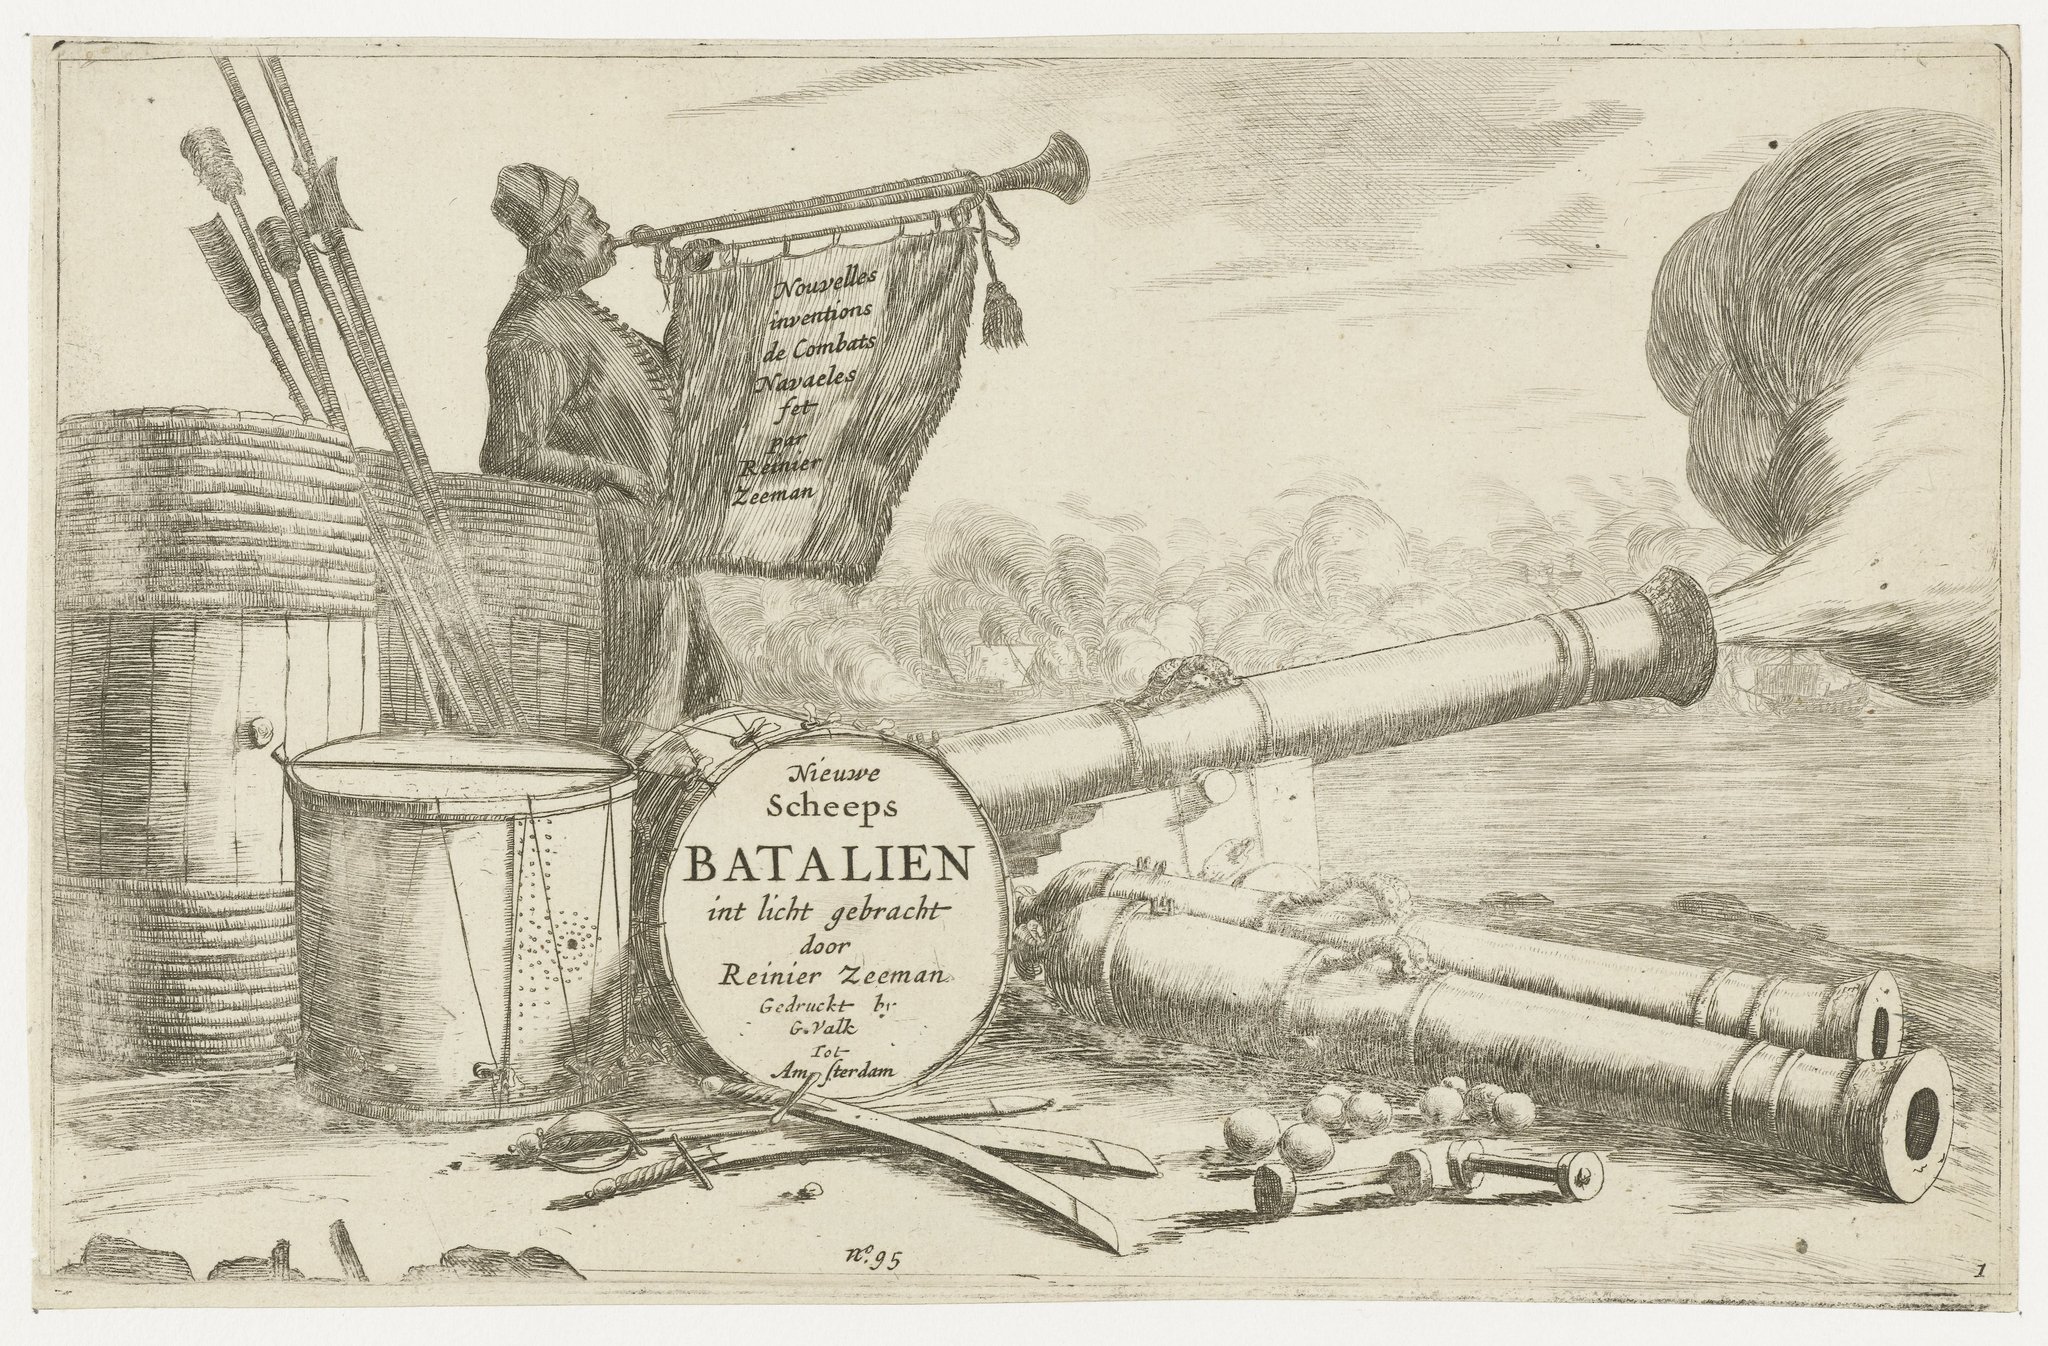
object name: print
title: Nouvelles inventions de Combats Navaeles par Reinier Zeeman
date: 1652-1656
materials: paper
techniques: drypoint, etching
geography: netherlands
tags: title-page, warfare; military affairs (+ naval force)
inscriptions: number: ‘No. 95’, collector's mark: Lugt 2228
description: Titelblad voor een reeks van zeeslagen. De uitrusting van een oorlogsschip waaronder kanonnen, kogels, kruitvaten en twee trommels. Een zeeman blaast op een trompet waaraan een vlag hangt.